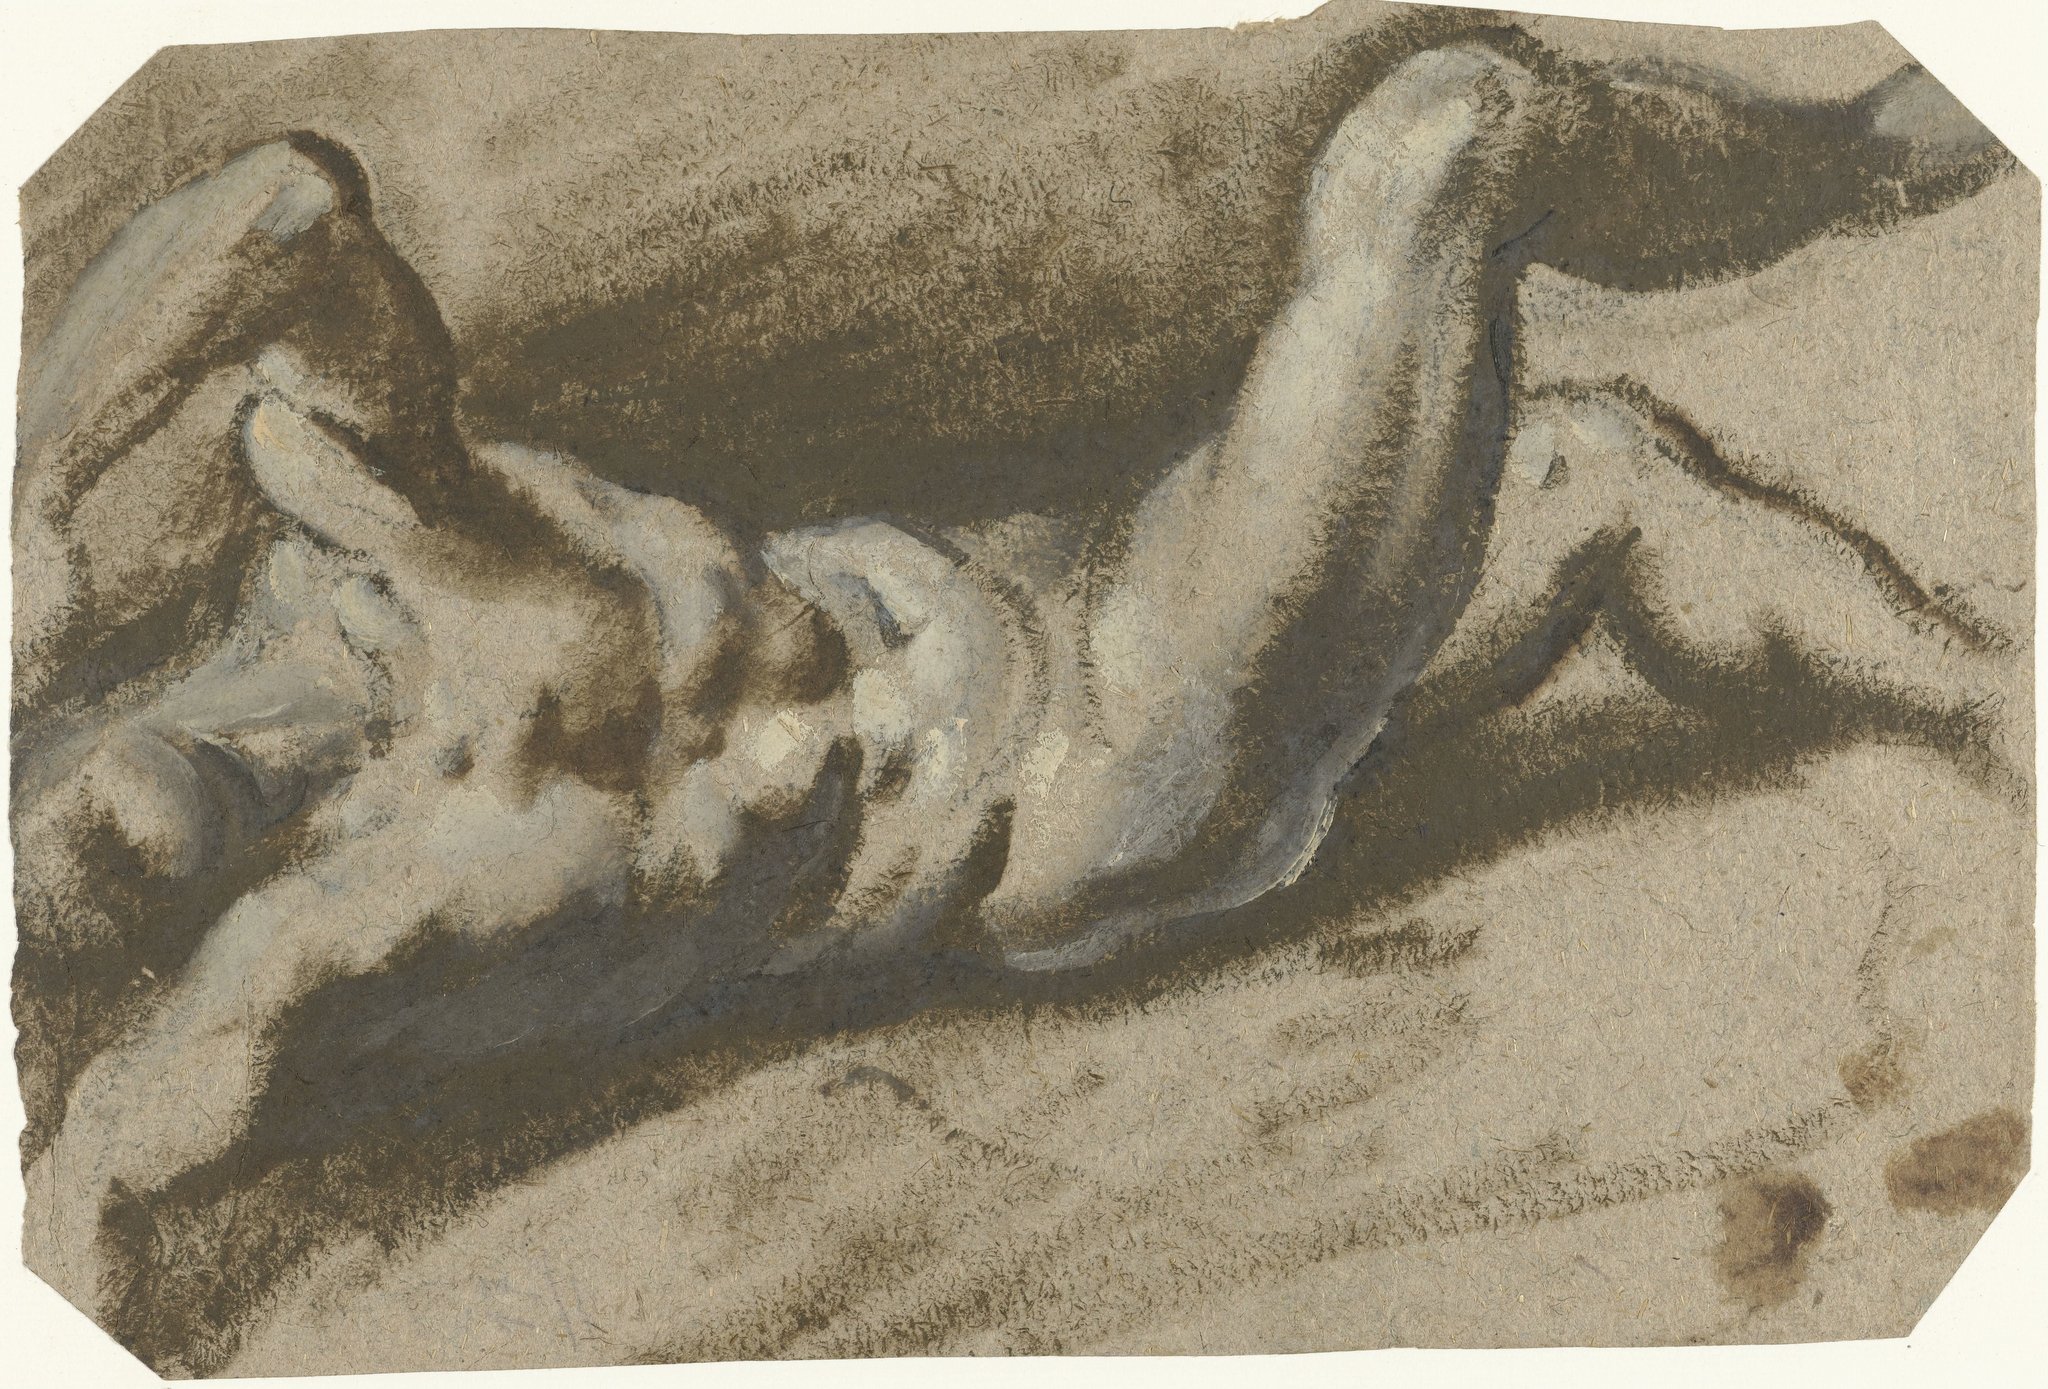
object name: drawing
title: Achteroverliggende naakte jongeman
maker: jacopo palma (il giovane)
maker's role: draughtsman, painter, print maker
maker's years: 1544-1628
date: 1554-1628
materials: paper, oil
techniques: brush